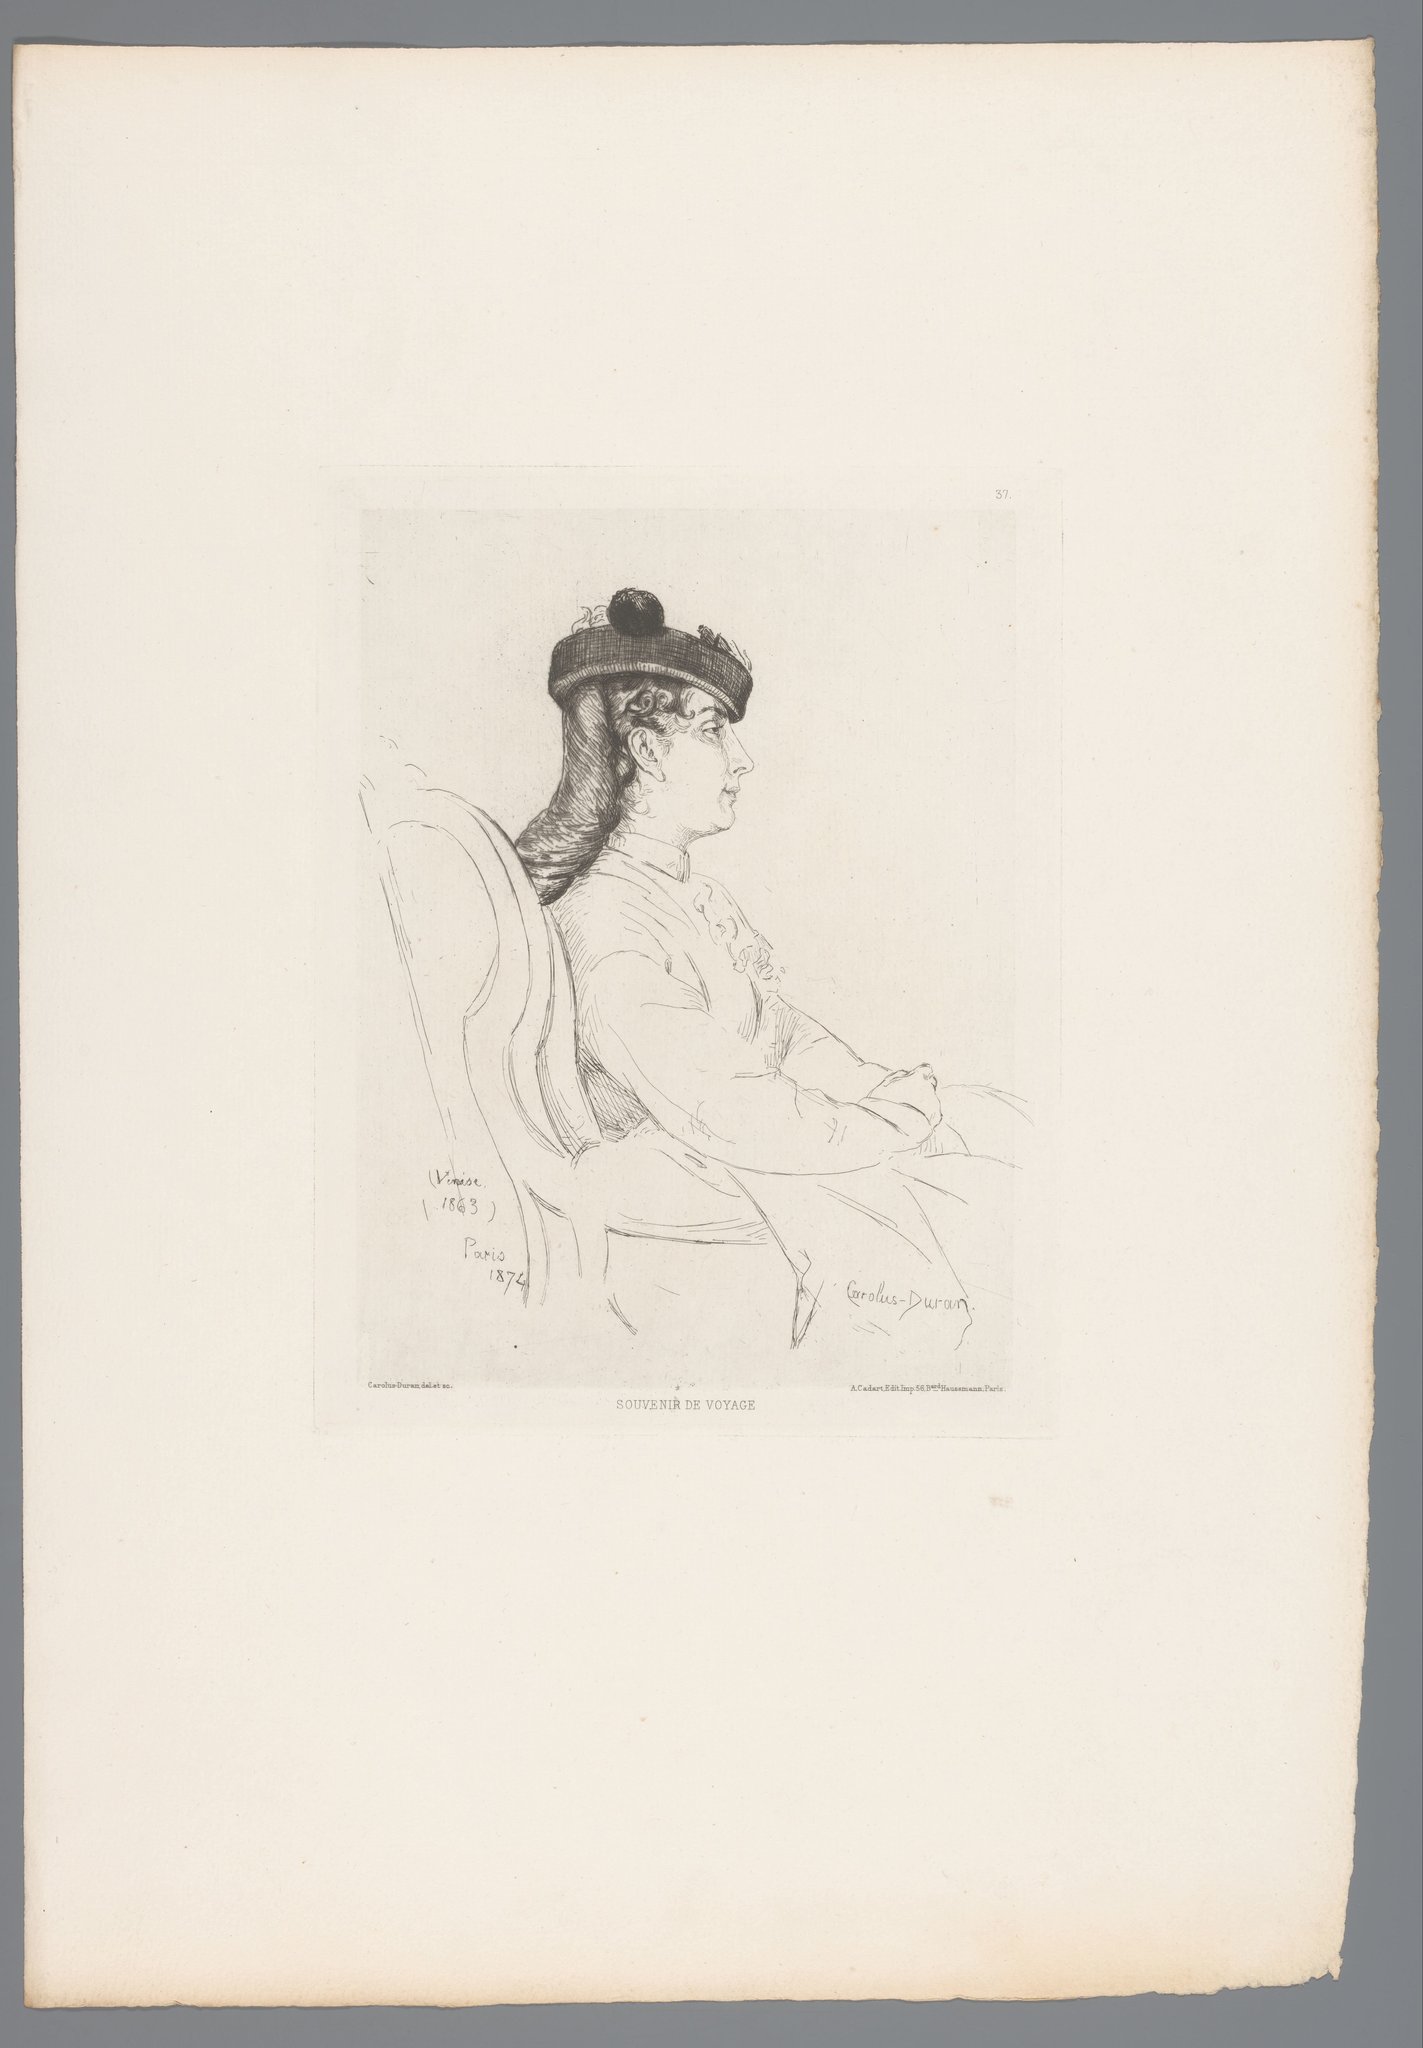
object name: print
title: Souvenir de voyage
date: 1875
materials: paper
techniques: drypoint, etching, intaglio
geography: paris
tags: sitting figure - aa - female human figure, historical persons not known by name - bb - woman, venice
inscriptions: collector's mark: Lugt 2228, collector's mark: Lugt 2760, collector's mark: ‘AFE v S’